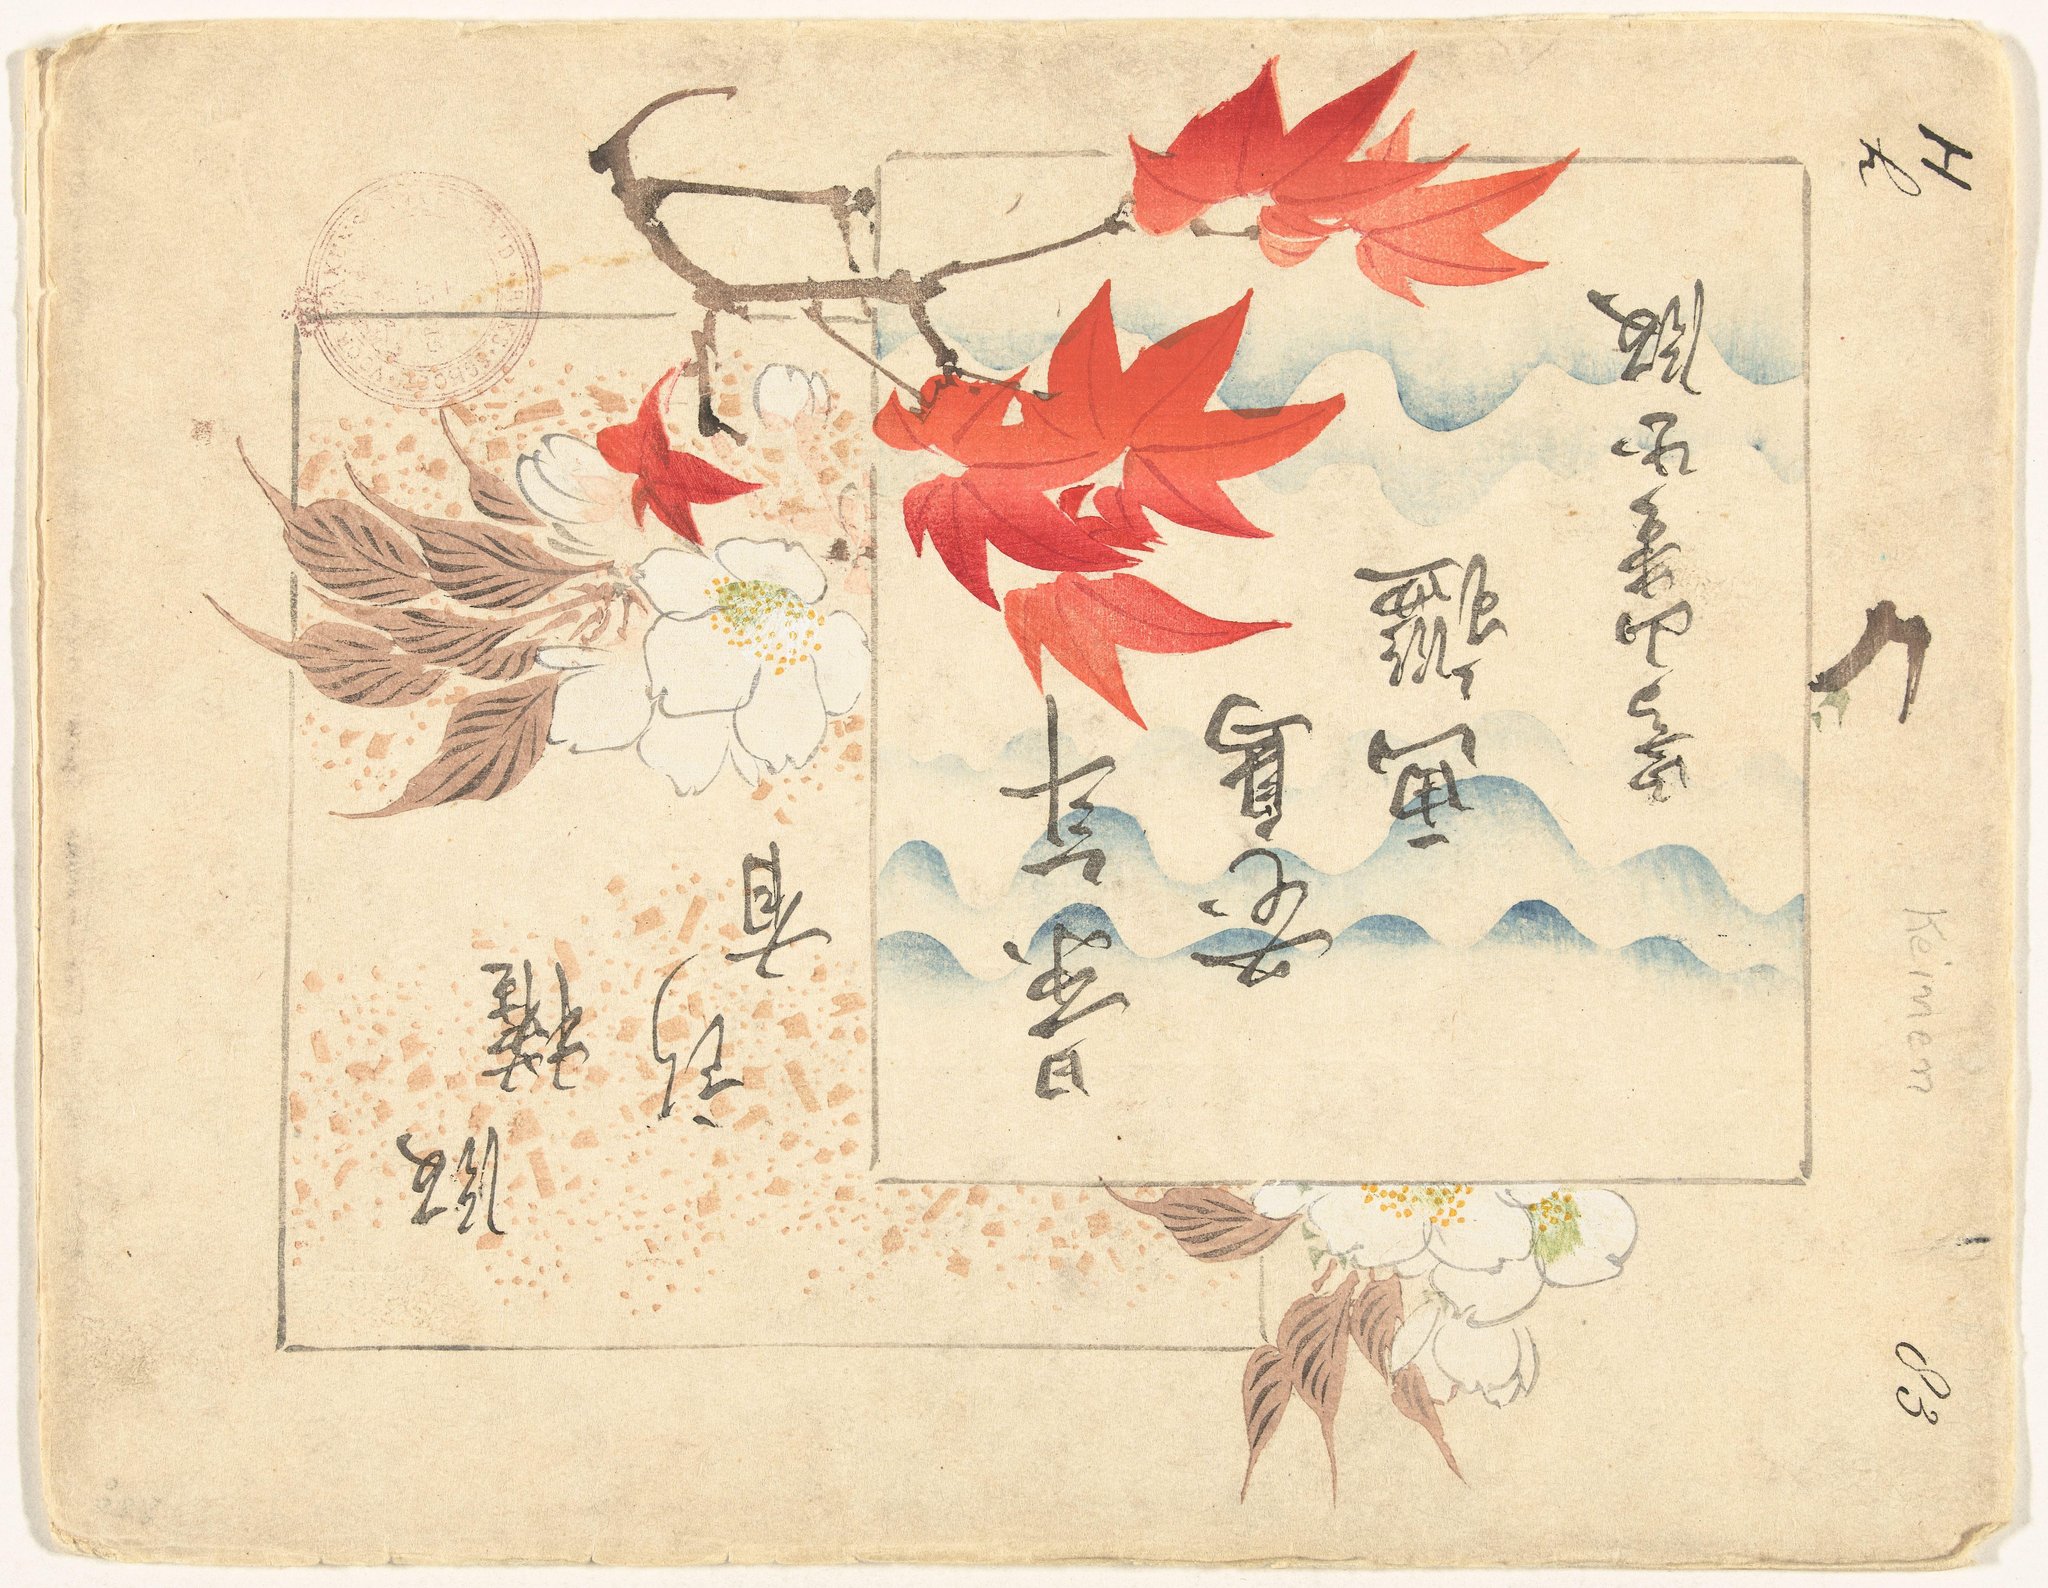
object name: print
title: Keinen kacho gafu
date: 1811-1892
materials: paper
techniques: woodcut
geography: osaka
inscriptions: collector's mark: Lugt 2228, collector's mark: ‘Rijksschool voor kunstnijverheid’ Lugt 3937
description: De originele omslag en de complete serie van twaalf prenten met afbeeldingen van vogels bij bloesemende bomen.